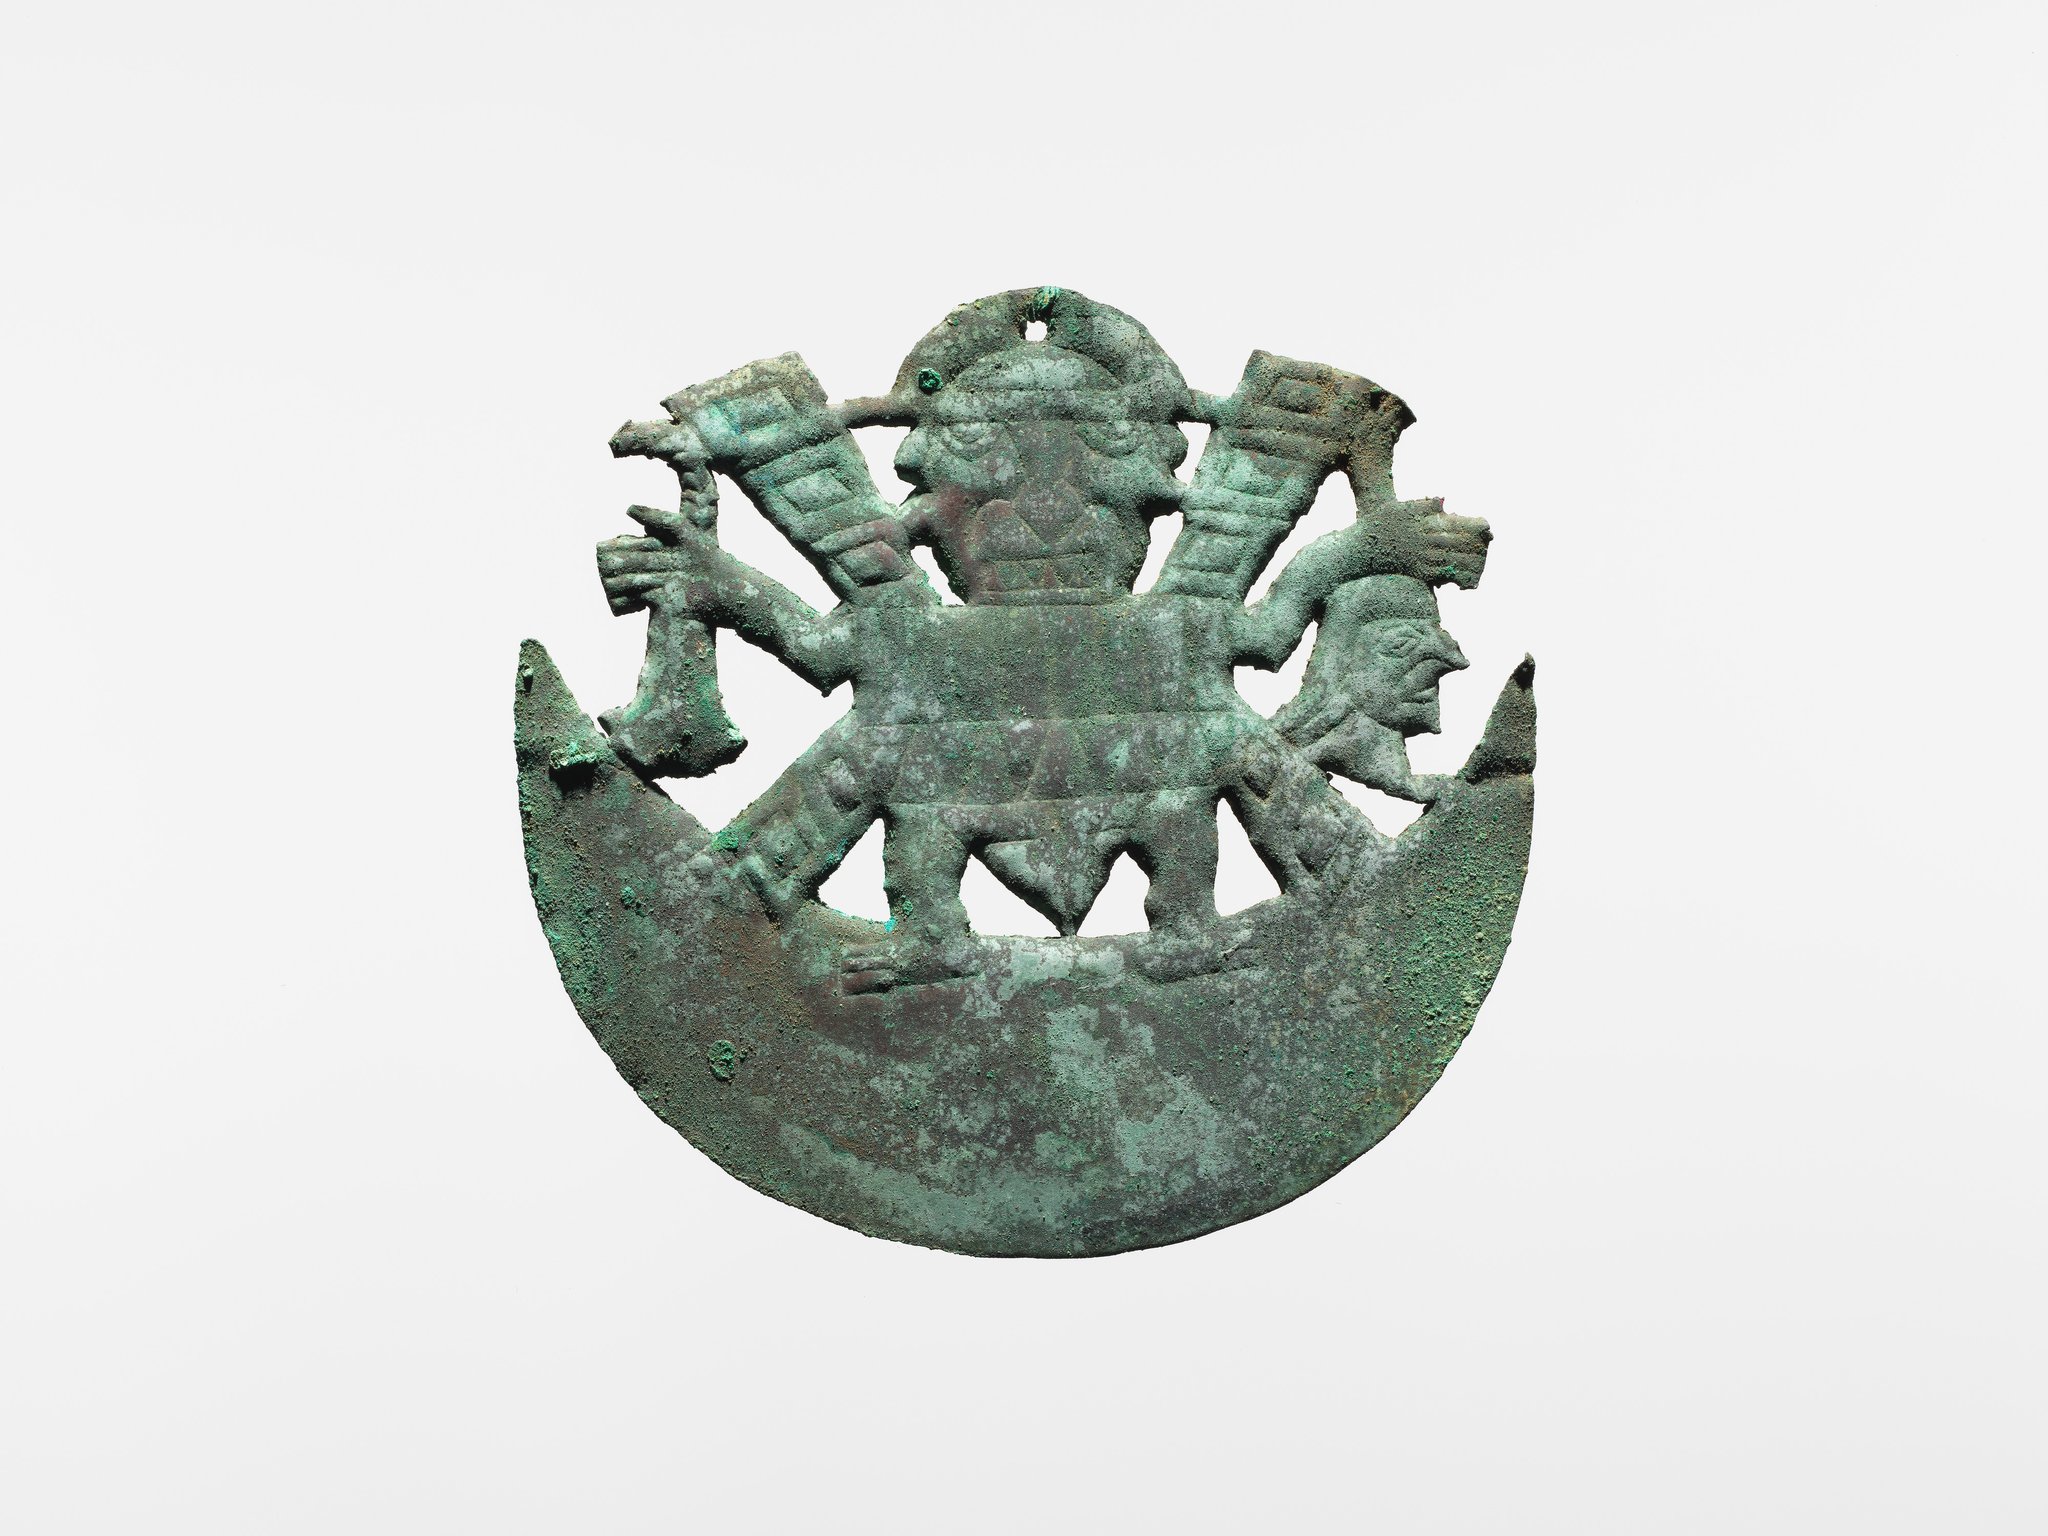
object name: ornament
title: Animal Ornament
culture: moche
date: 501-700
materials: copper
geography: peru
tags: animals